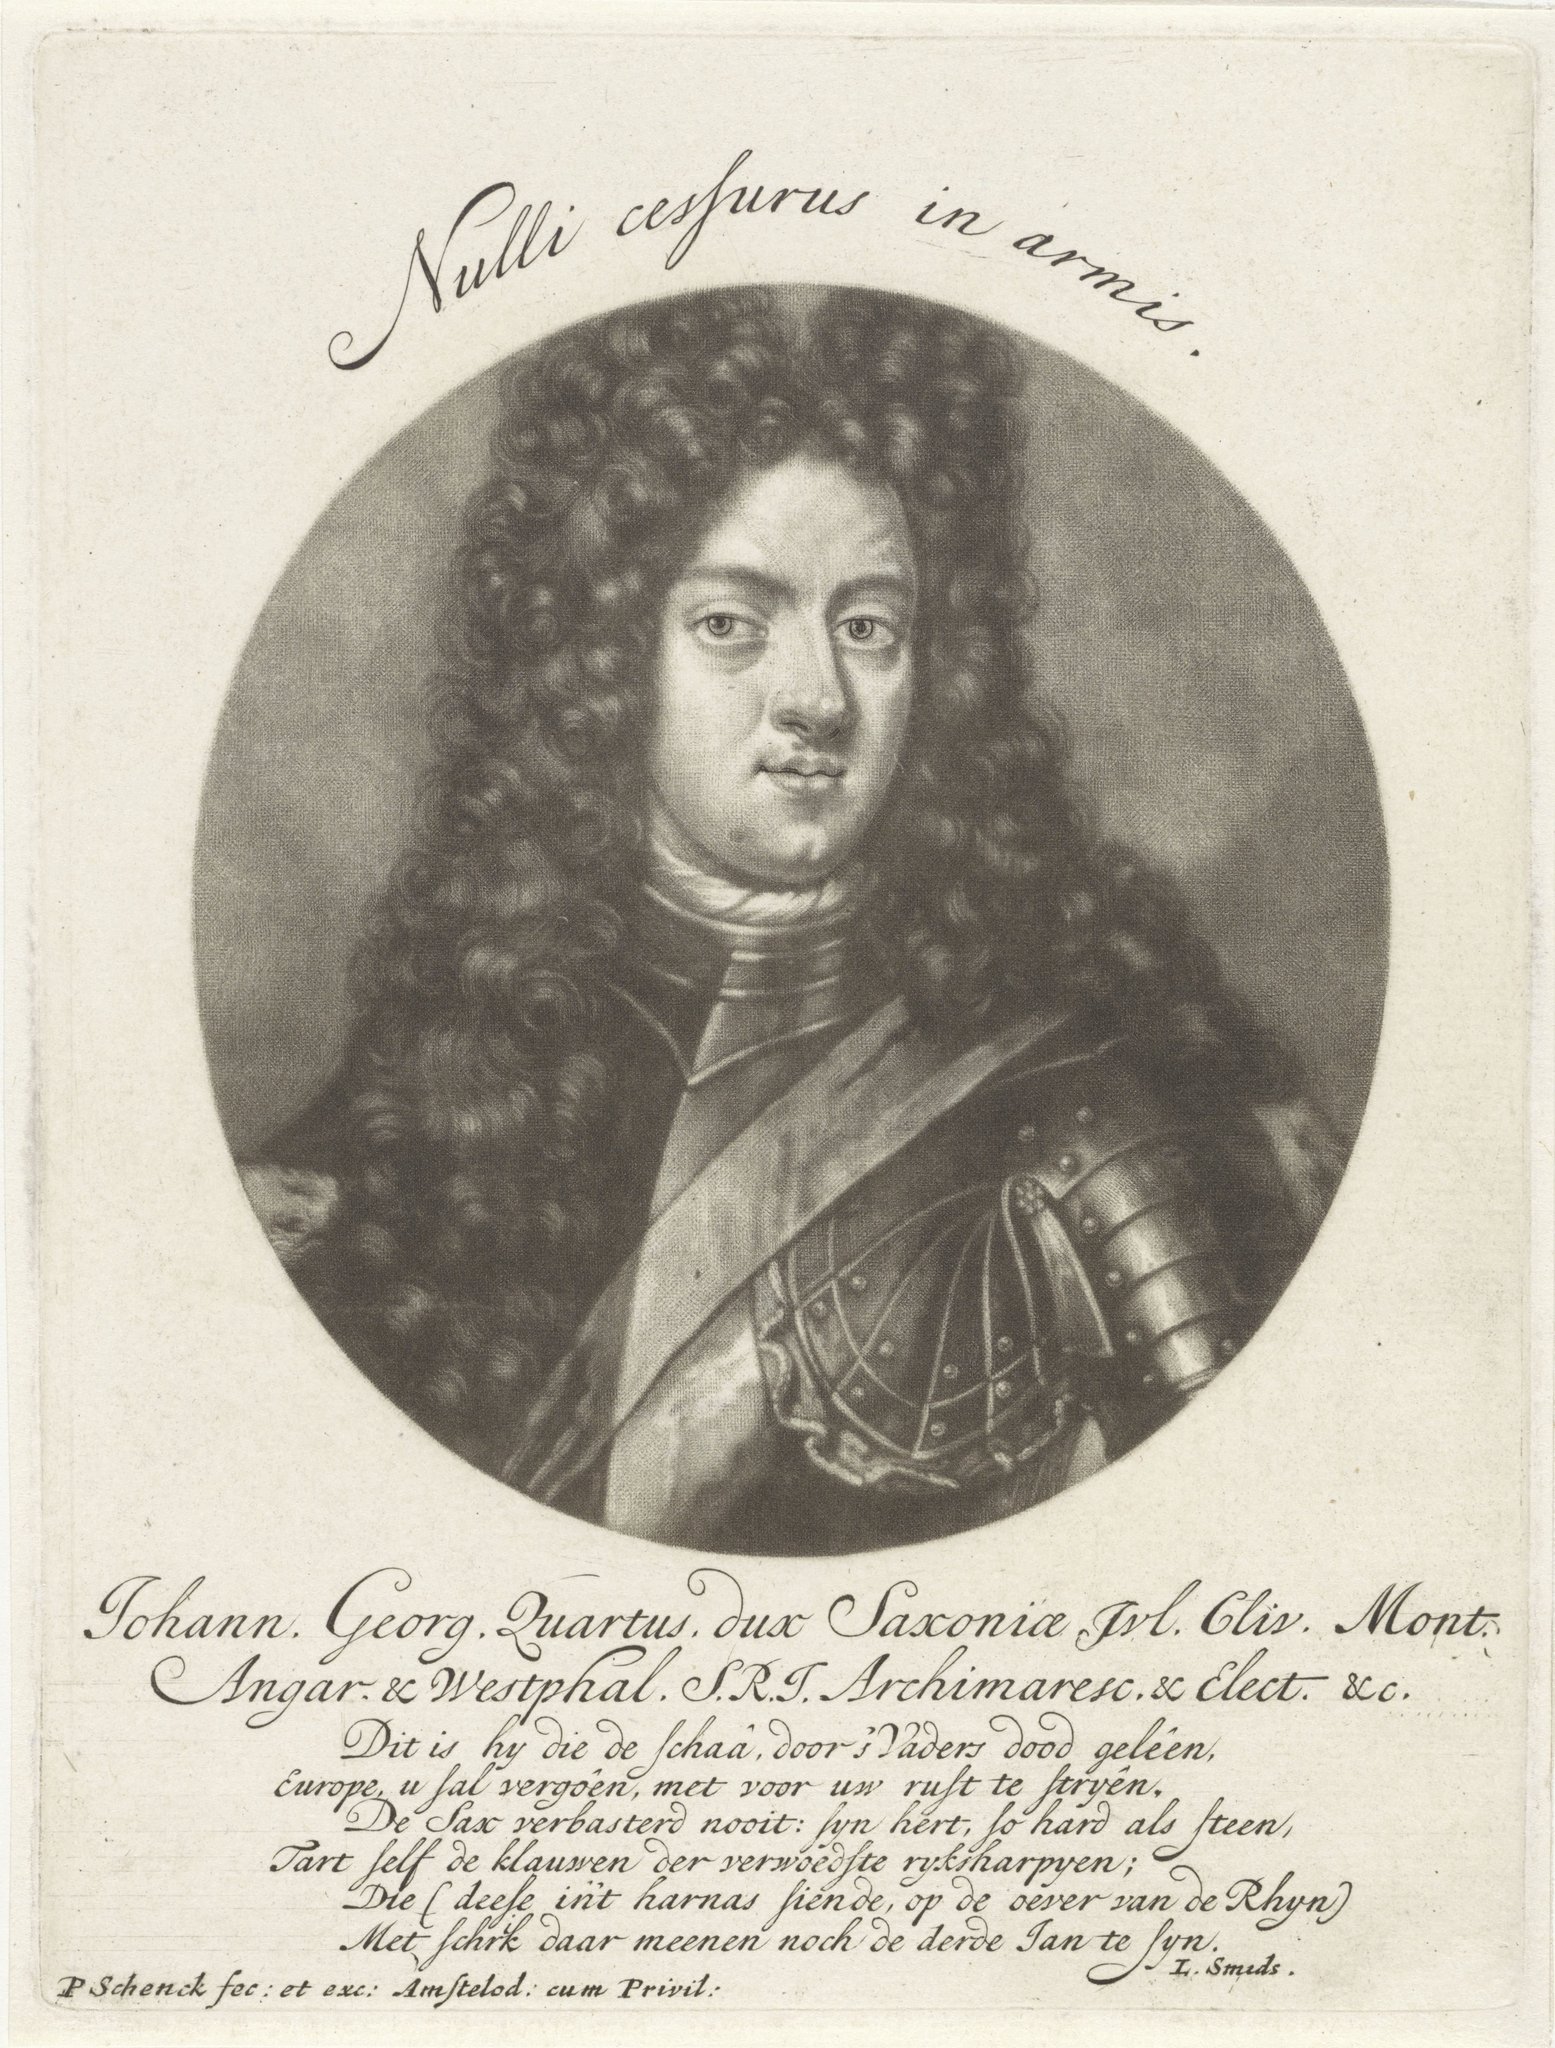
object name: print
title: Portret van Johan Georg IV van Saksen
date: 1670-1713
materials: paper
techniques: engraving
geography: amsterdam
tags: wig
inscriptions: collector's mark: Lugt 2228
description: Johan Georg IV, keurvorst van Saksen, draagt een harnas en een pruik. In de marge een lofdicht op zijn strijdkunsten en het Saksisch hertogelijk geslacht.